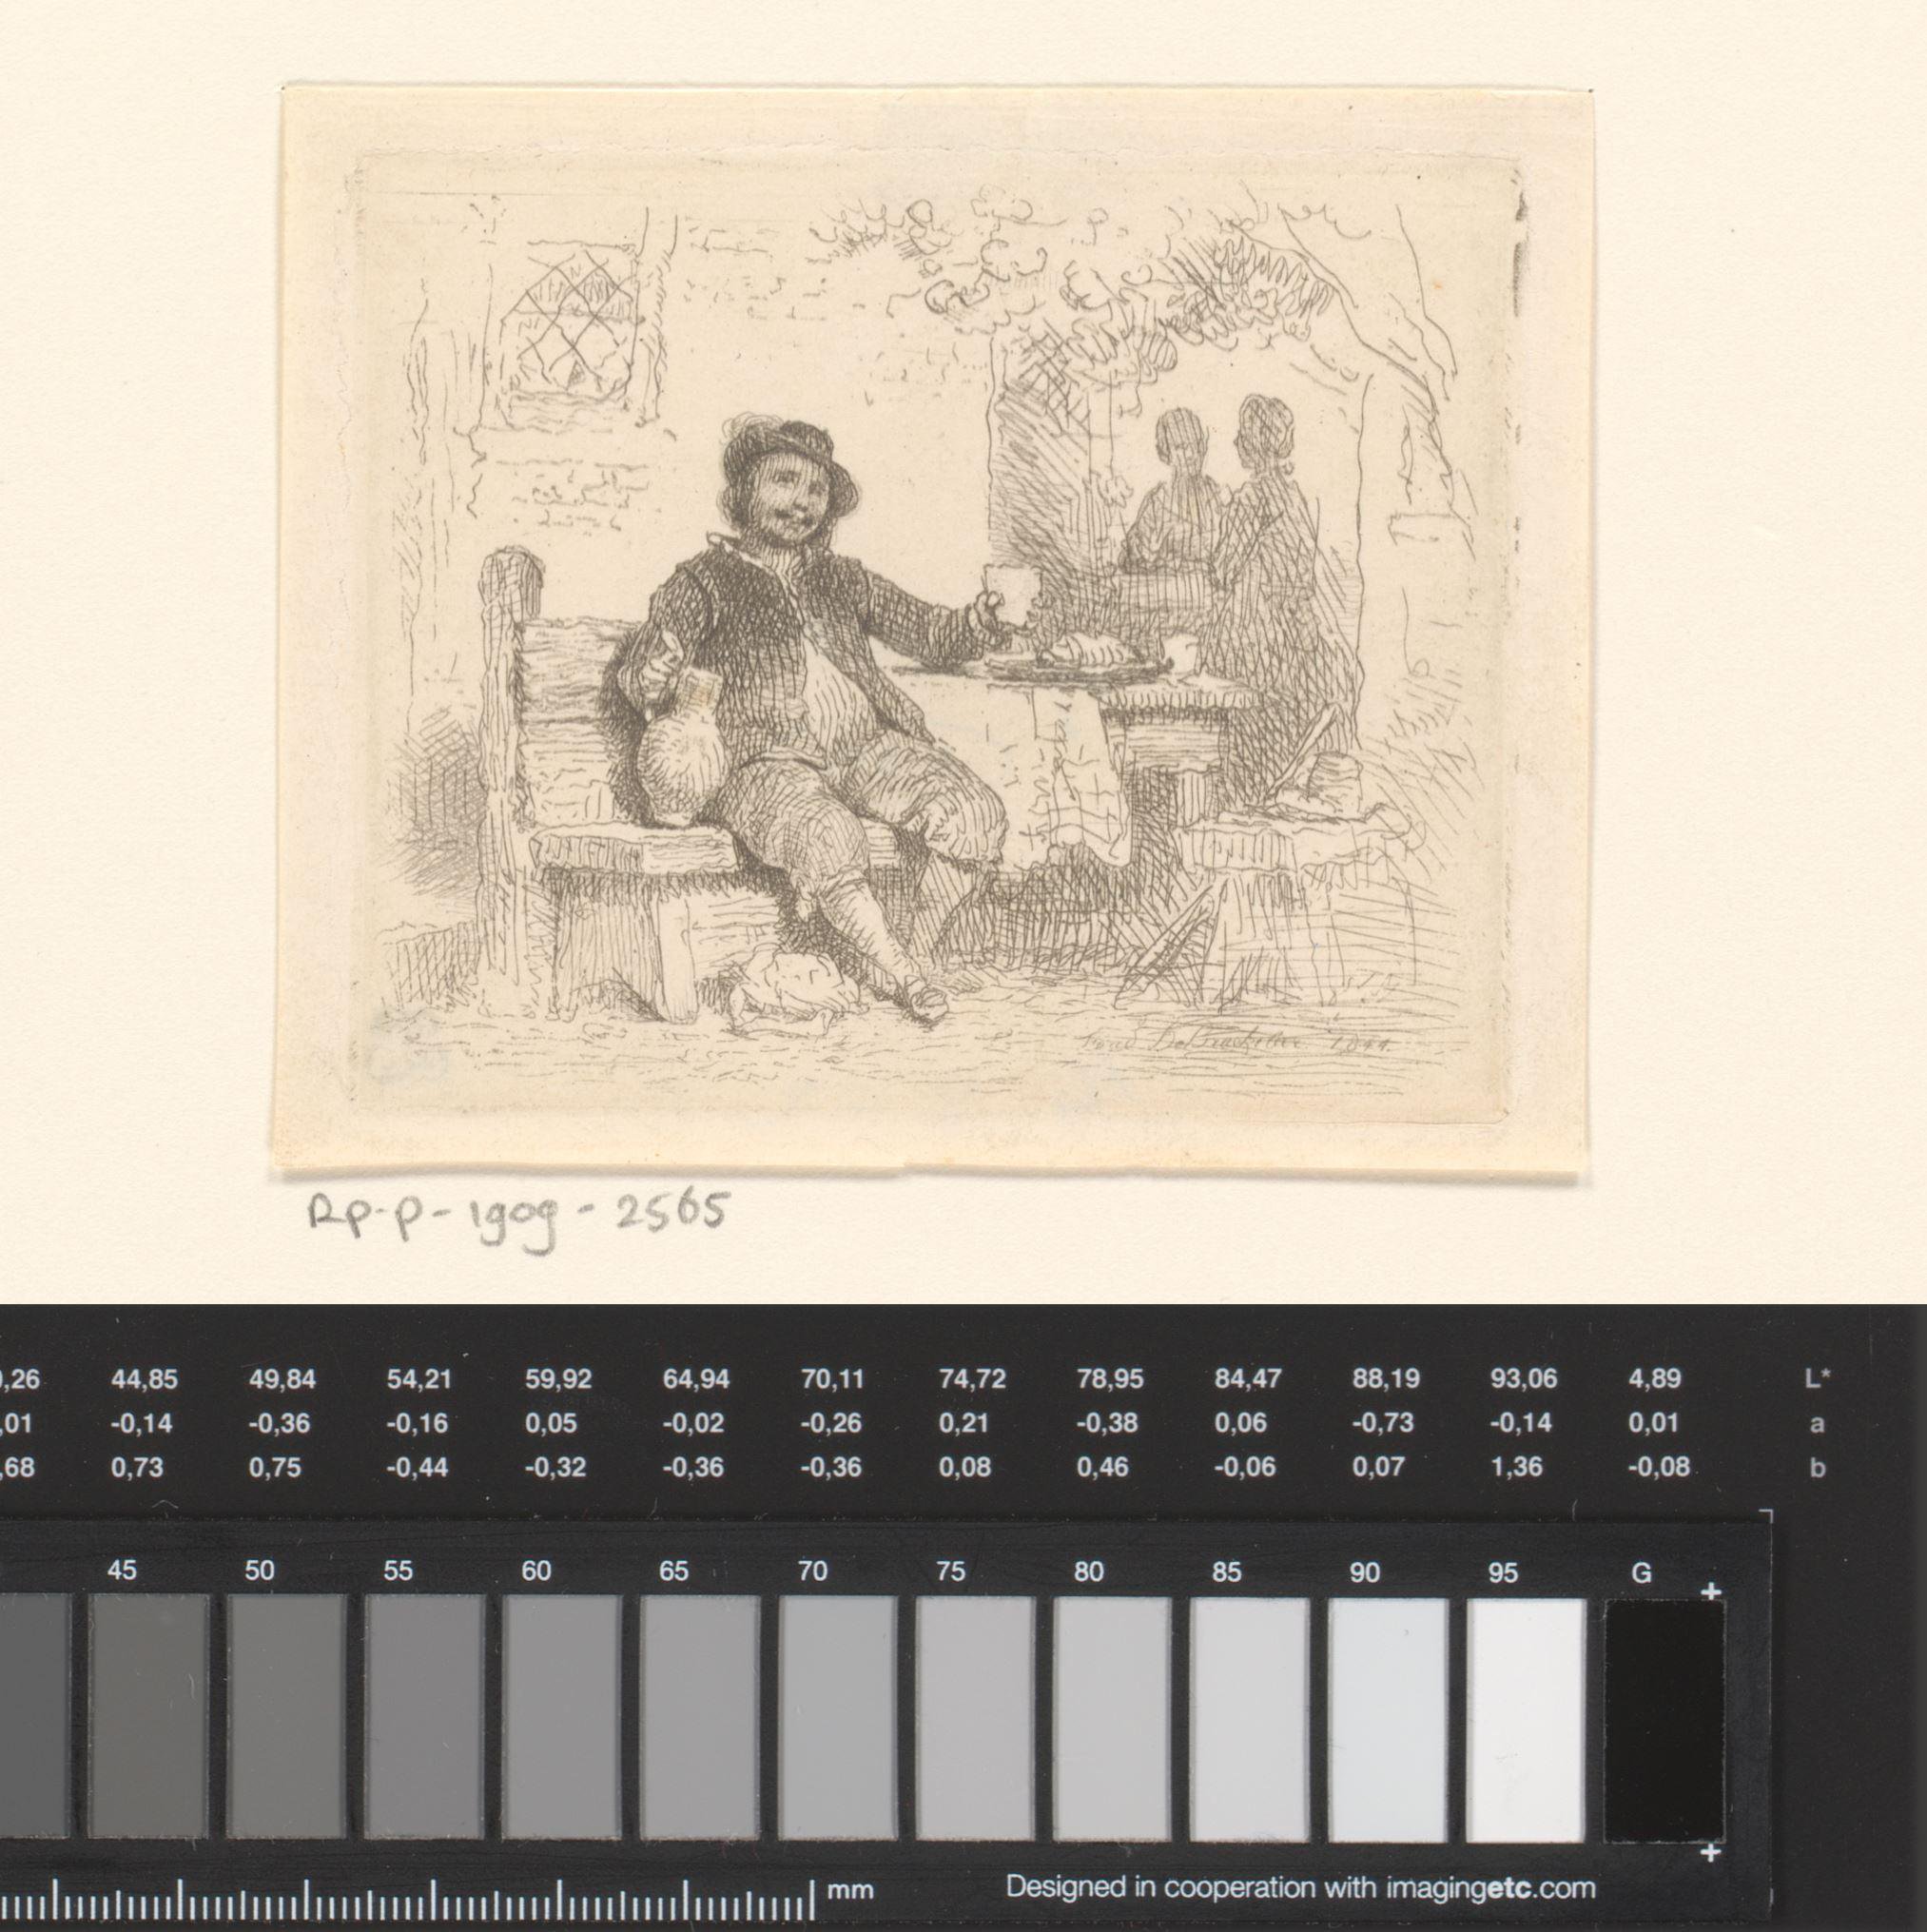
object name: print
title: Drinkende man zittend voor een herberg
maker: ferdinand de braekeleer (i)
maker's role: draughtsman, print maker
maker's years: 1792-1883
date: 1844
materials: paper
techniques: etching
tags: drinking, hotel, hostelry, inn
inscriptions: collector's mark: Lugt 1485, collector's mark: Lugt 2228